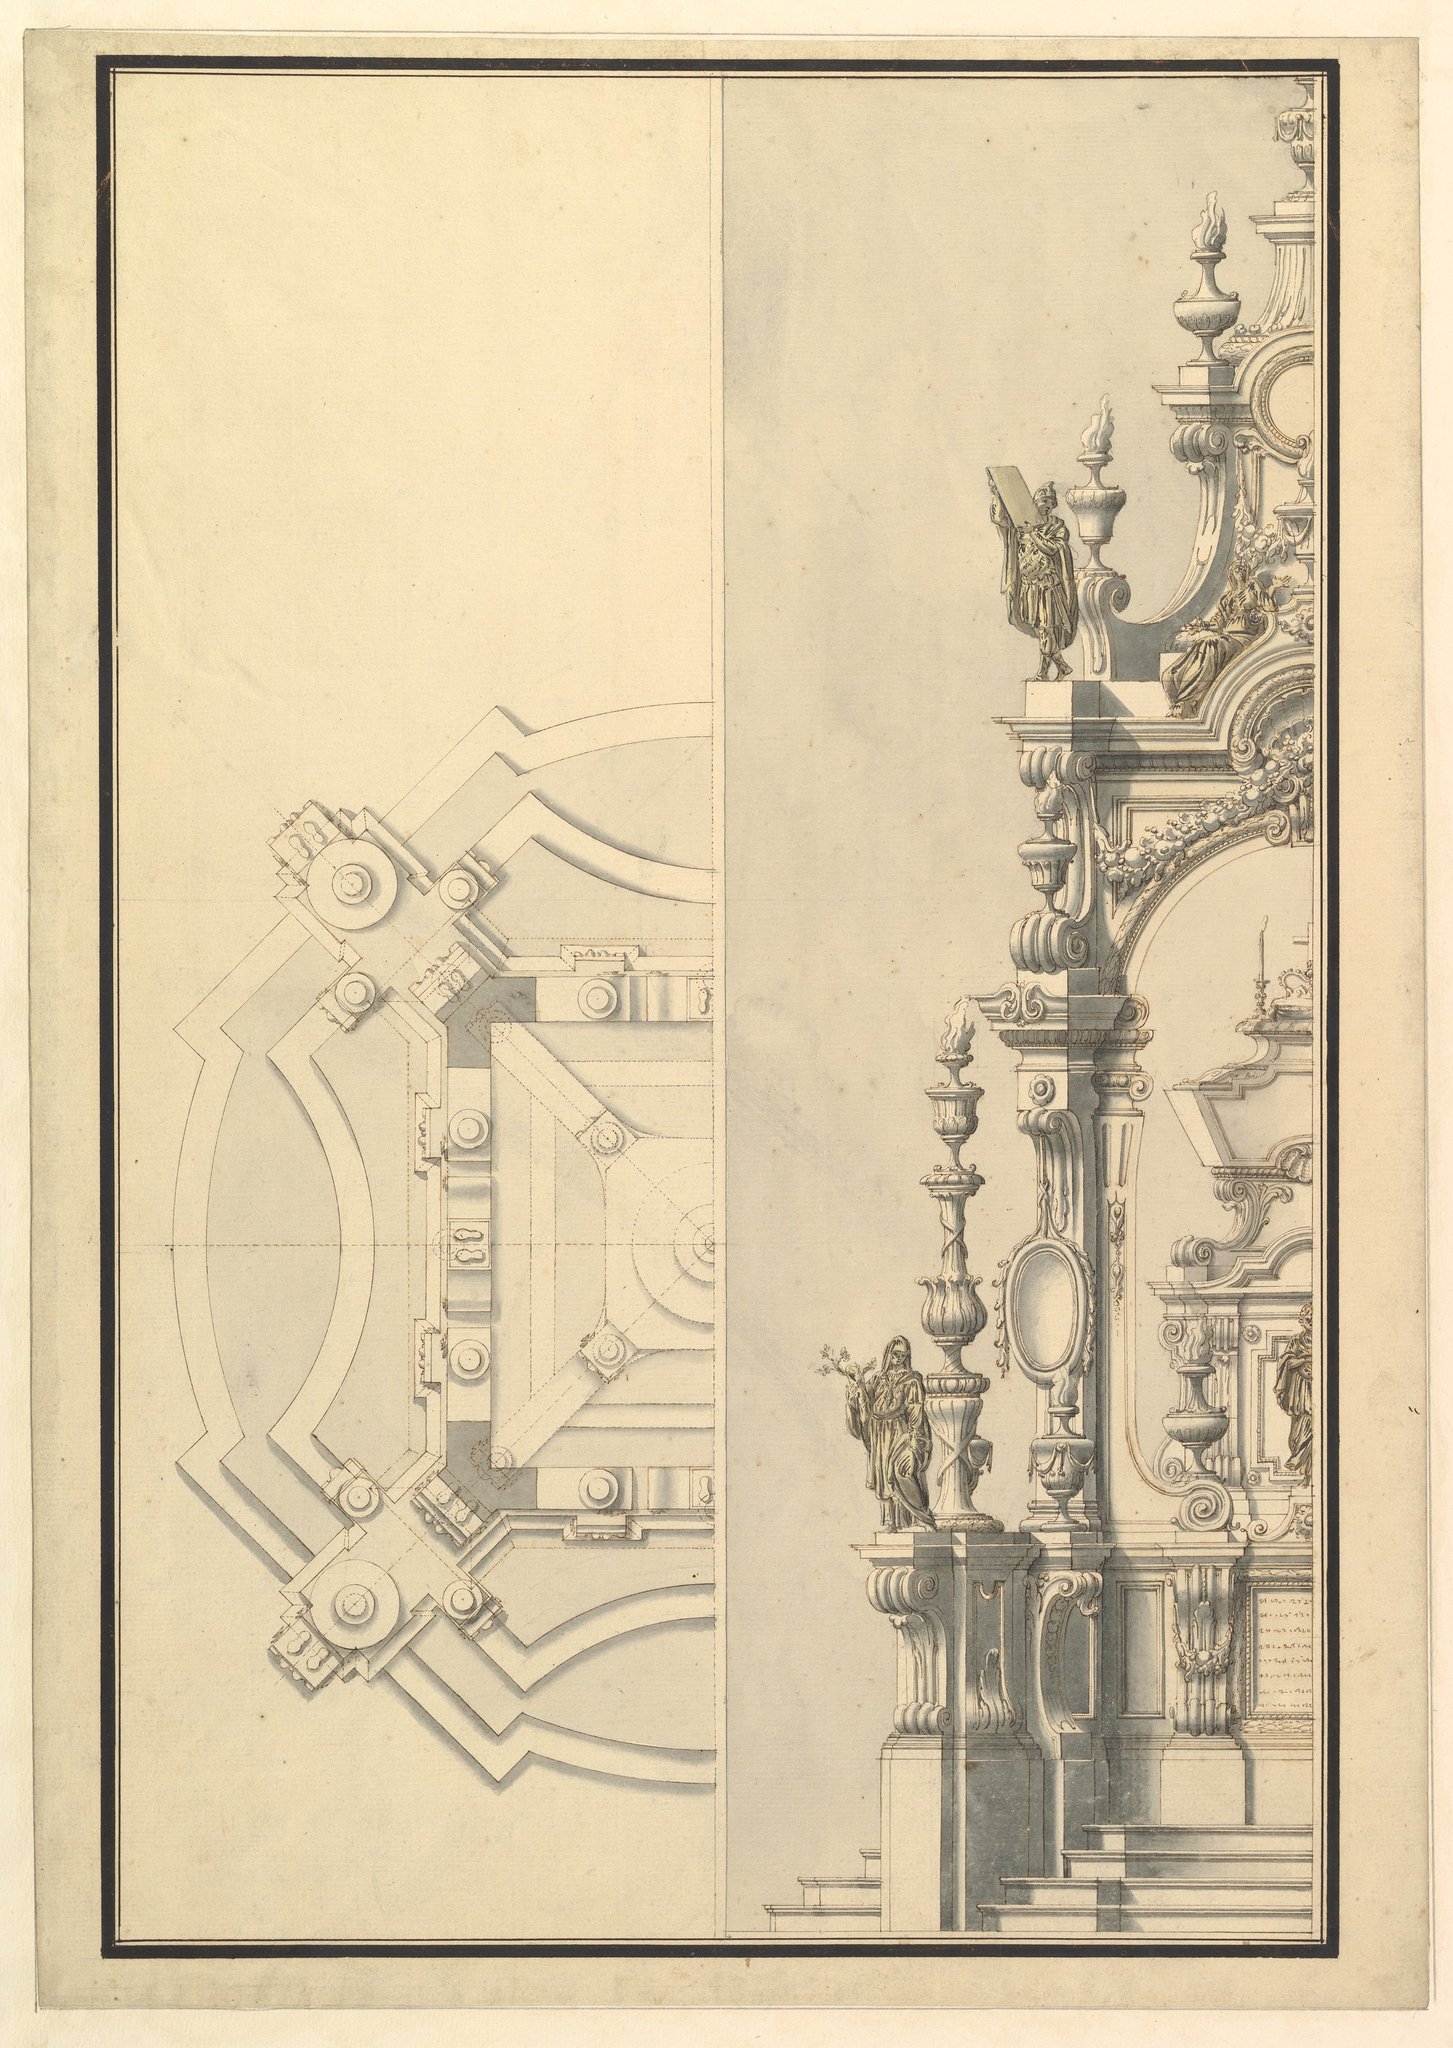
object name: drawing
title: Half Ground Plan and Half Elevation for a Catafalque with Royal Crown Surmounting Casket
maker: giuseppe galli bibiena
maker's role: artist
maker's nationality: italian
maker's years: 1696-1756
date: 1696-1756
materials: ink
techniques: pen, wash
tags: architecture